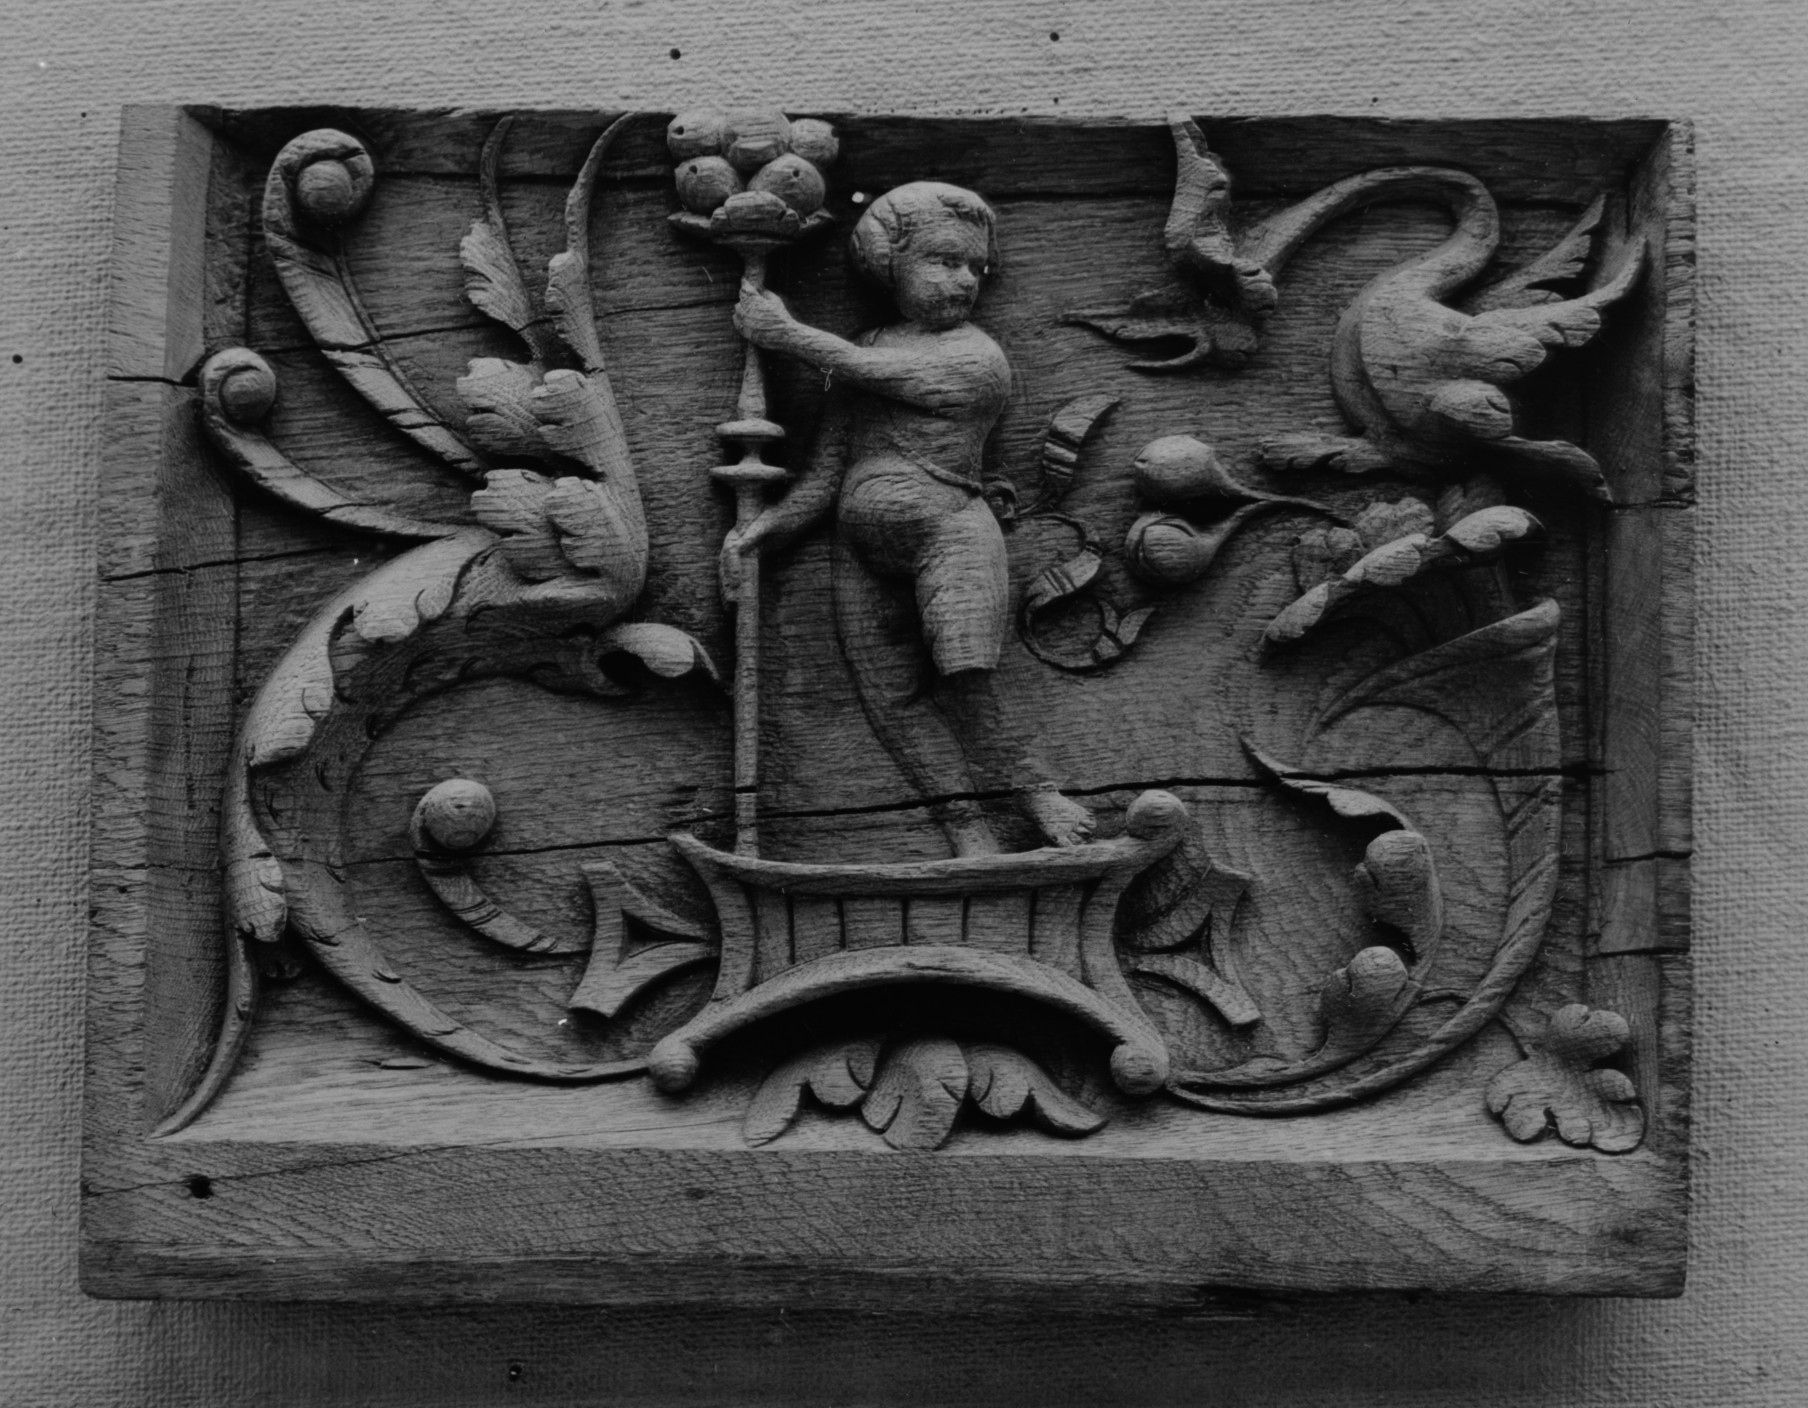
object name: panel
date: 1501-1600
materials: wood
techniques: carving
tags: birds,cupid